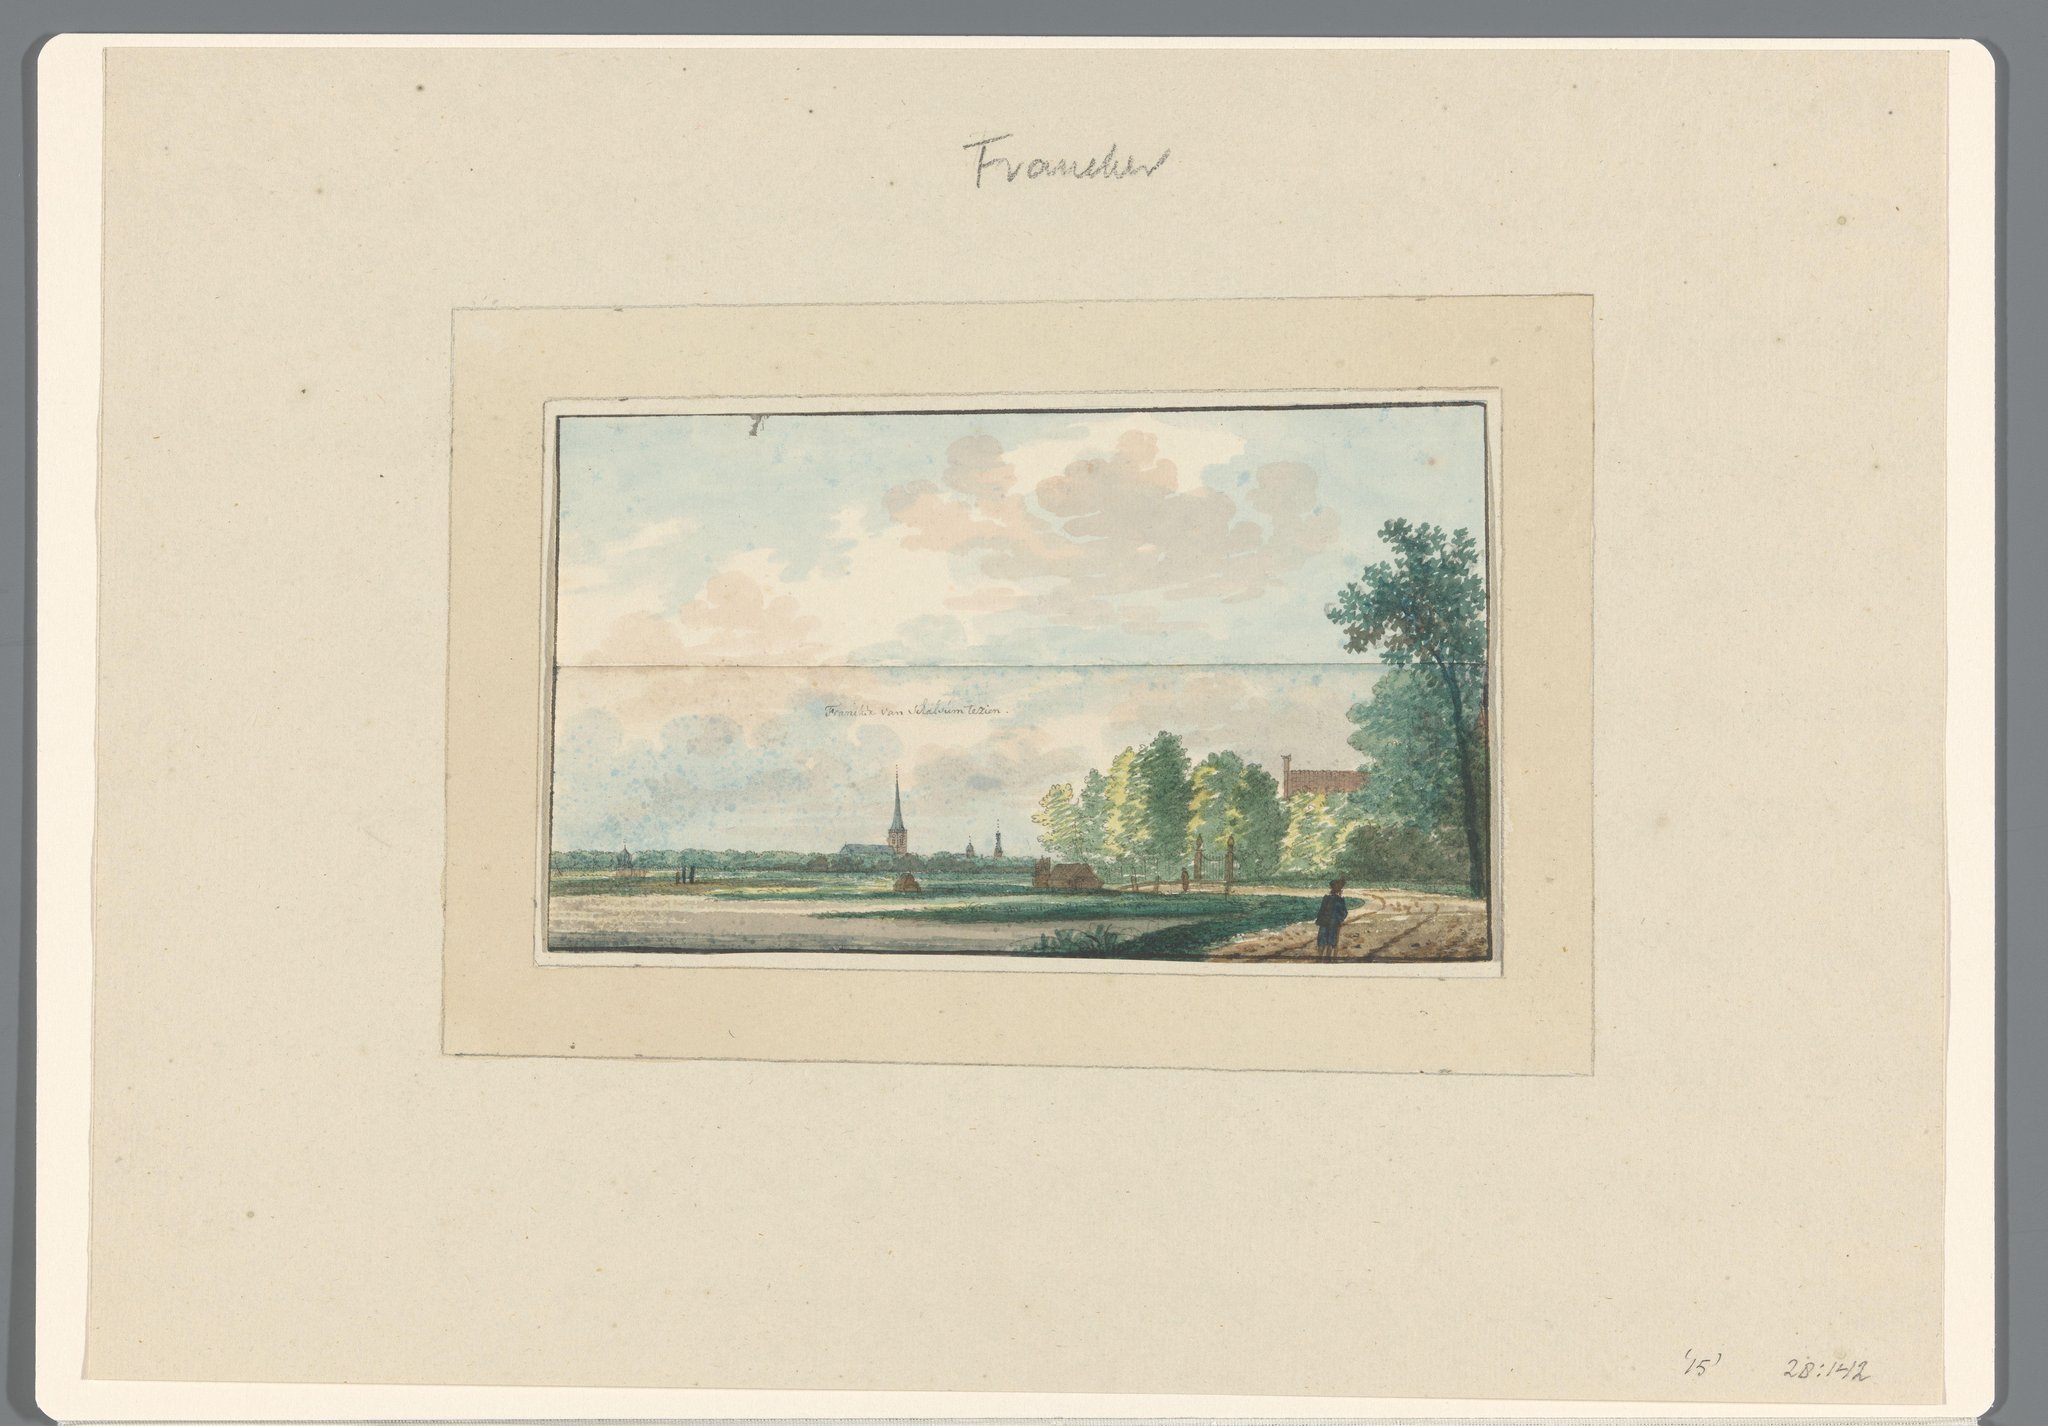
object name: drawing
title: Gezicht op Franeker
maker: Anonymous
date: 1700-1800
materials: ink, paper, pencil, watercolor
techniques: brush, pen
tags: prospect of city, town panorama, silhouette of city